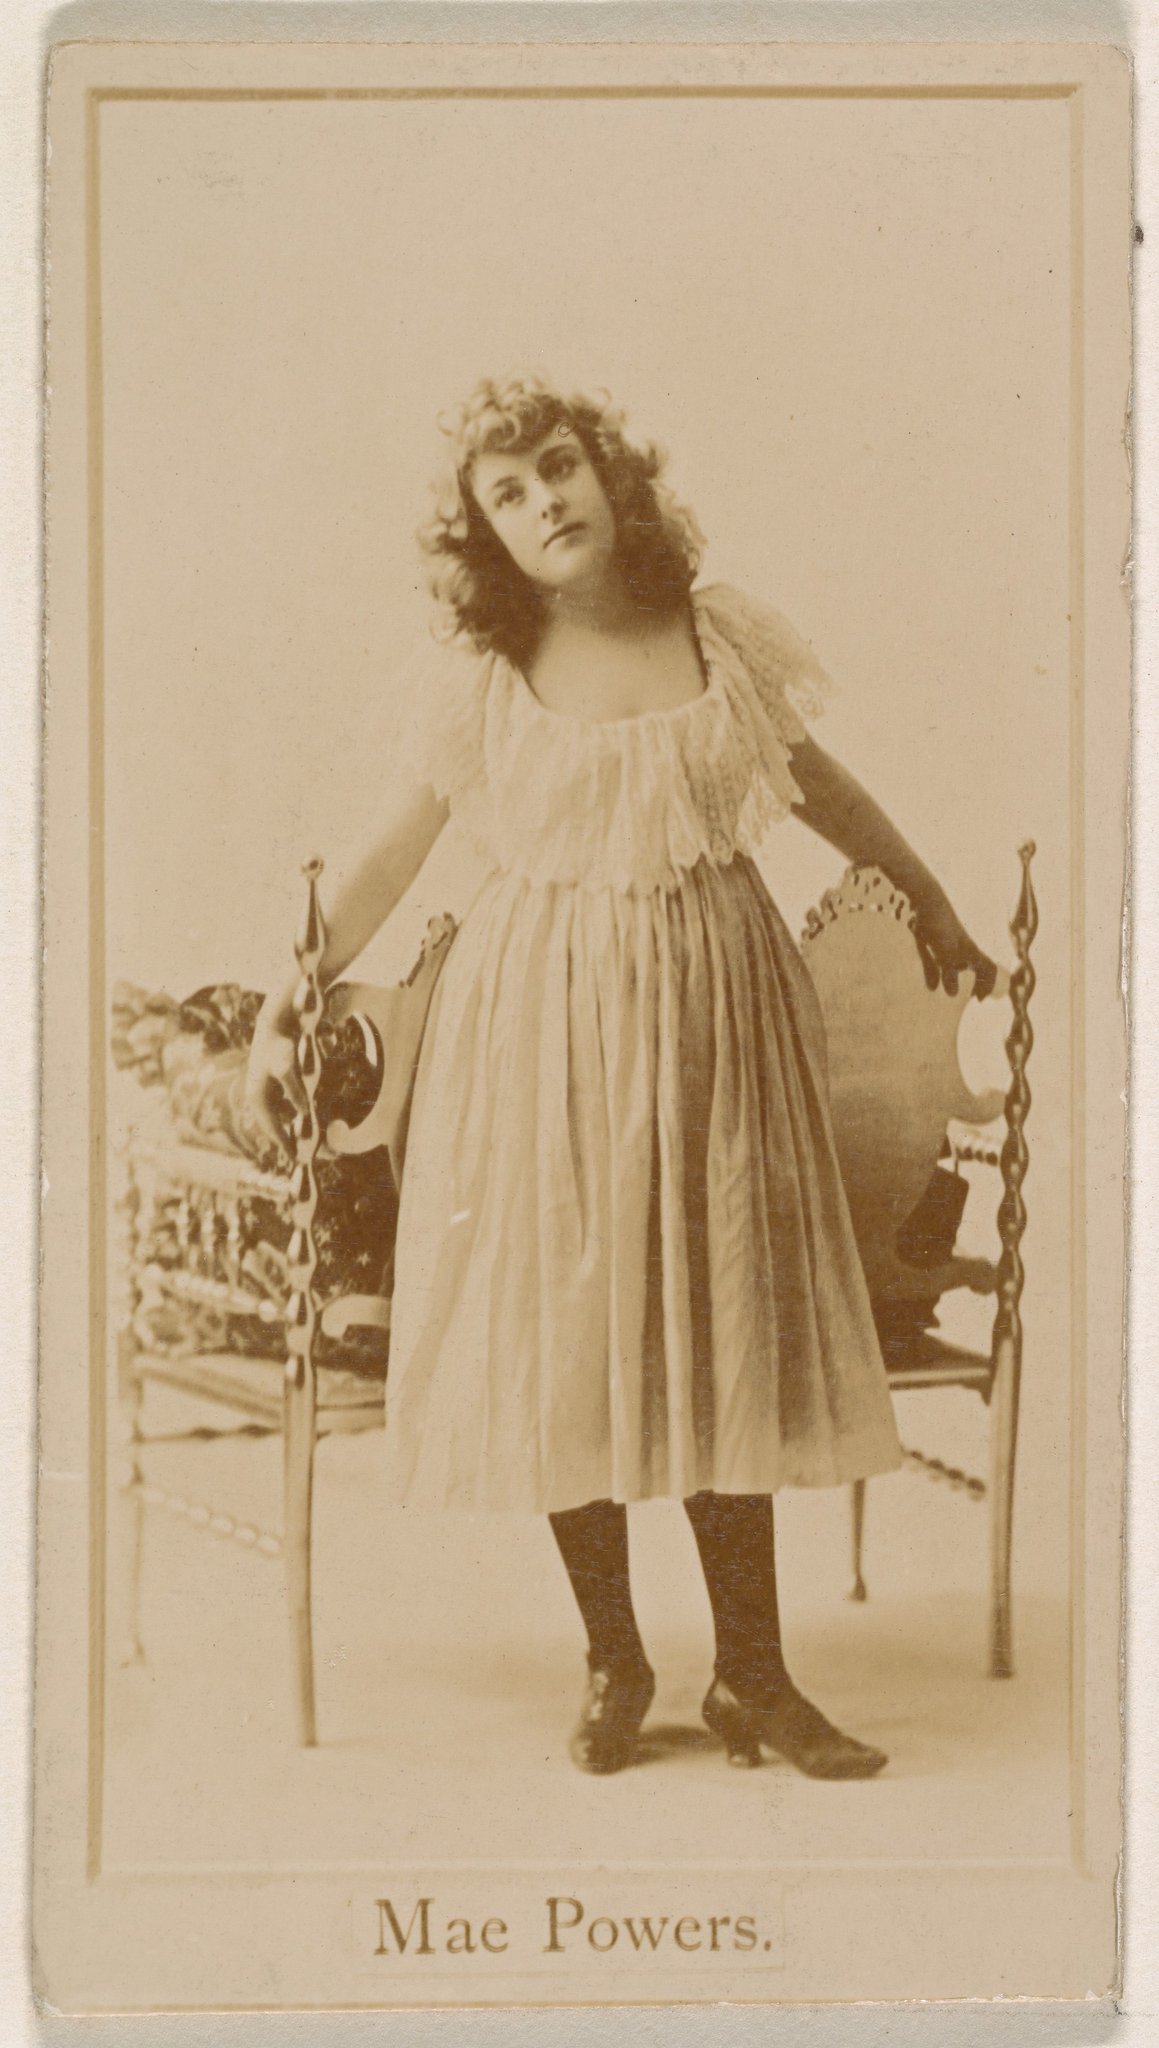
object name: photograph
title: Mae Powers, from the Actresses series (N245) issued by Kinney Brothers to promote Sweet Caporal Cigarettes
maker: kinney brothers tobacco company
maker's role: publisher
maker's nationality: american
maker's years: 1869-2011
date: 1890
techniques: albumen silver print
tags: portraits,women,actresses